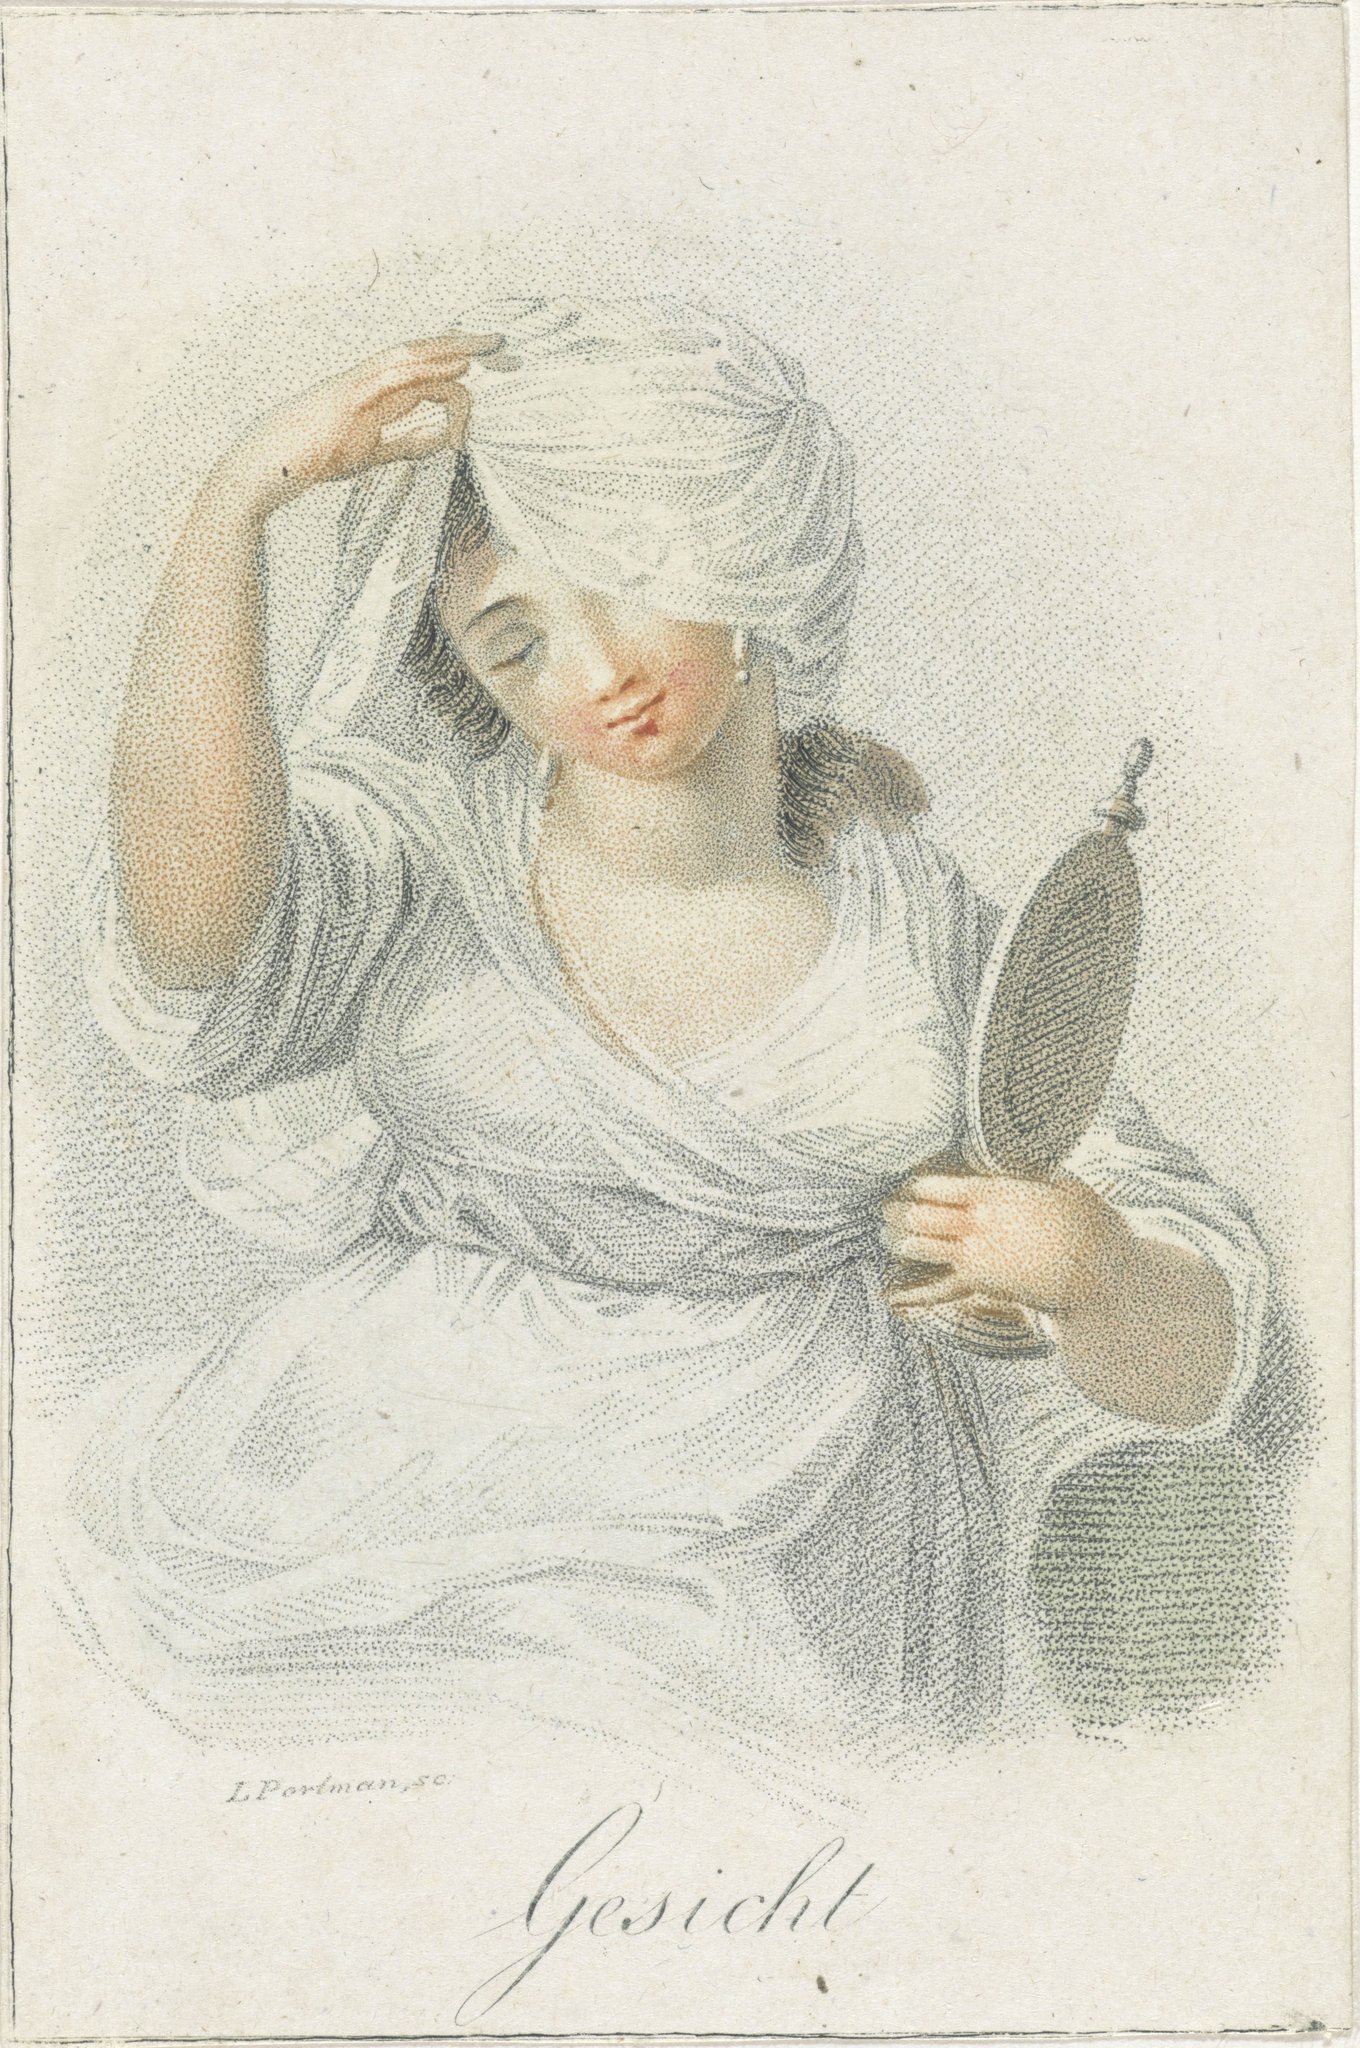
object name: print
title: Die Funf Sinne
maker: ludwig gottlieb portman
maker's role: print maker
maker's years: 1772-1828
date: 1787-1828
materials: paper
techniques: printing, hand coloring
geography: northern netherlands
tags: sight, looking (one of the five senses)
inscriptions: collector's mark: Lugt 2228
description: Een vrouw tilt haar sluier op om haar gezicht te tonen. In haar hand houdt ze een spiegel.